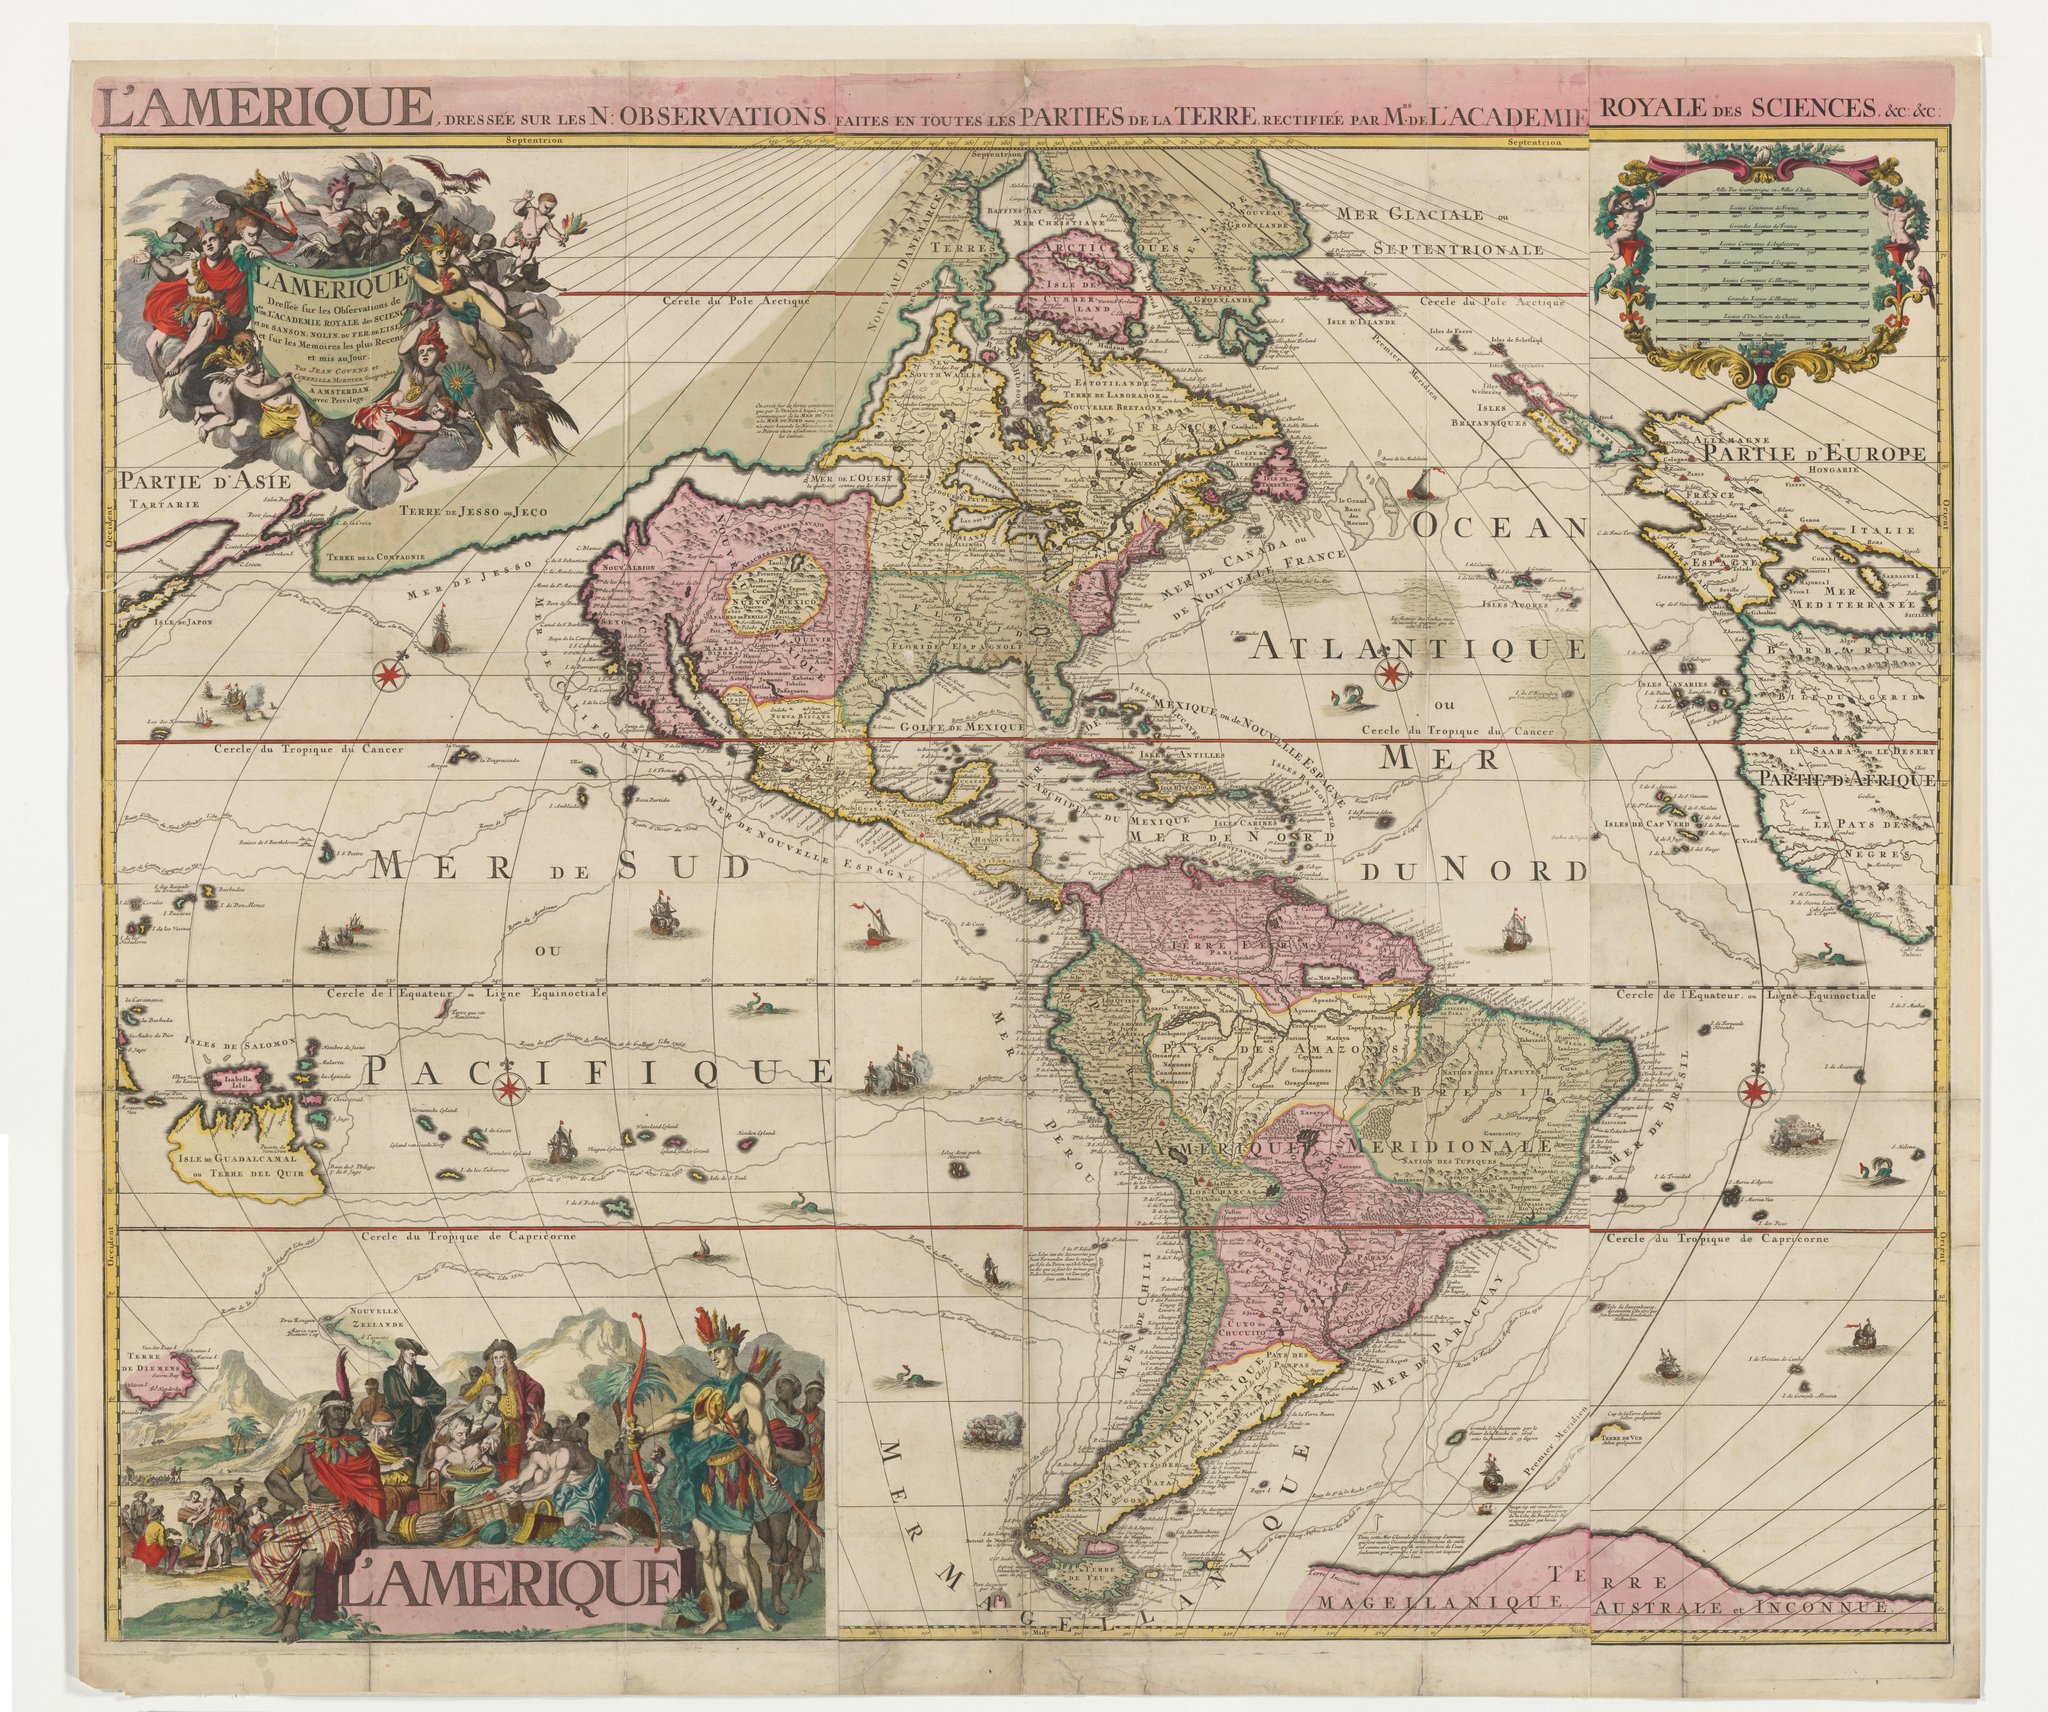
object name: map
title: Kaart van Amerika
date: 1721-1774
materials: paper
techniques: engraving, etching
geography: amsterdam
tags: native peoples of the americas, (map of) america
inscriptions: collector's mark: Lugt 2228